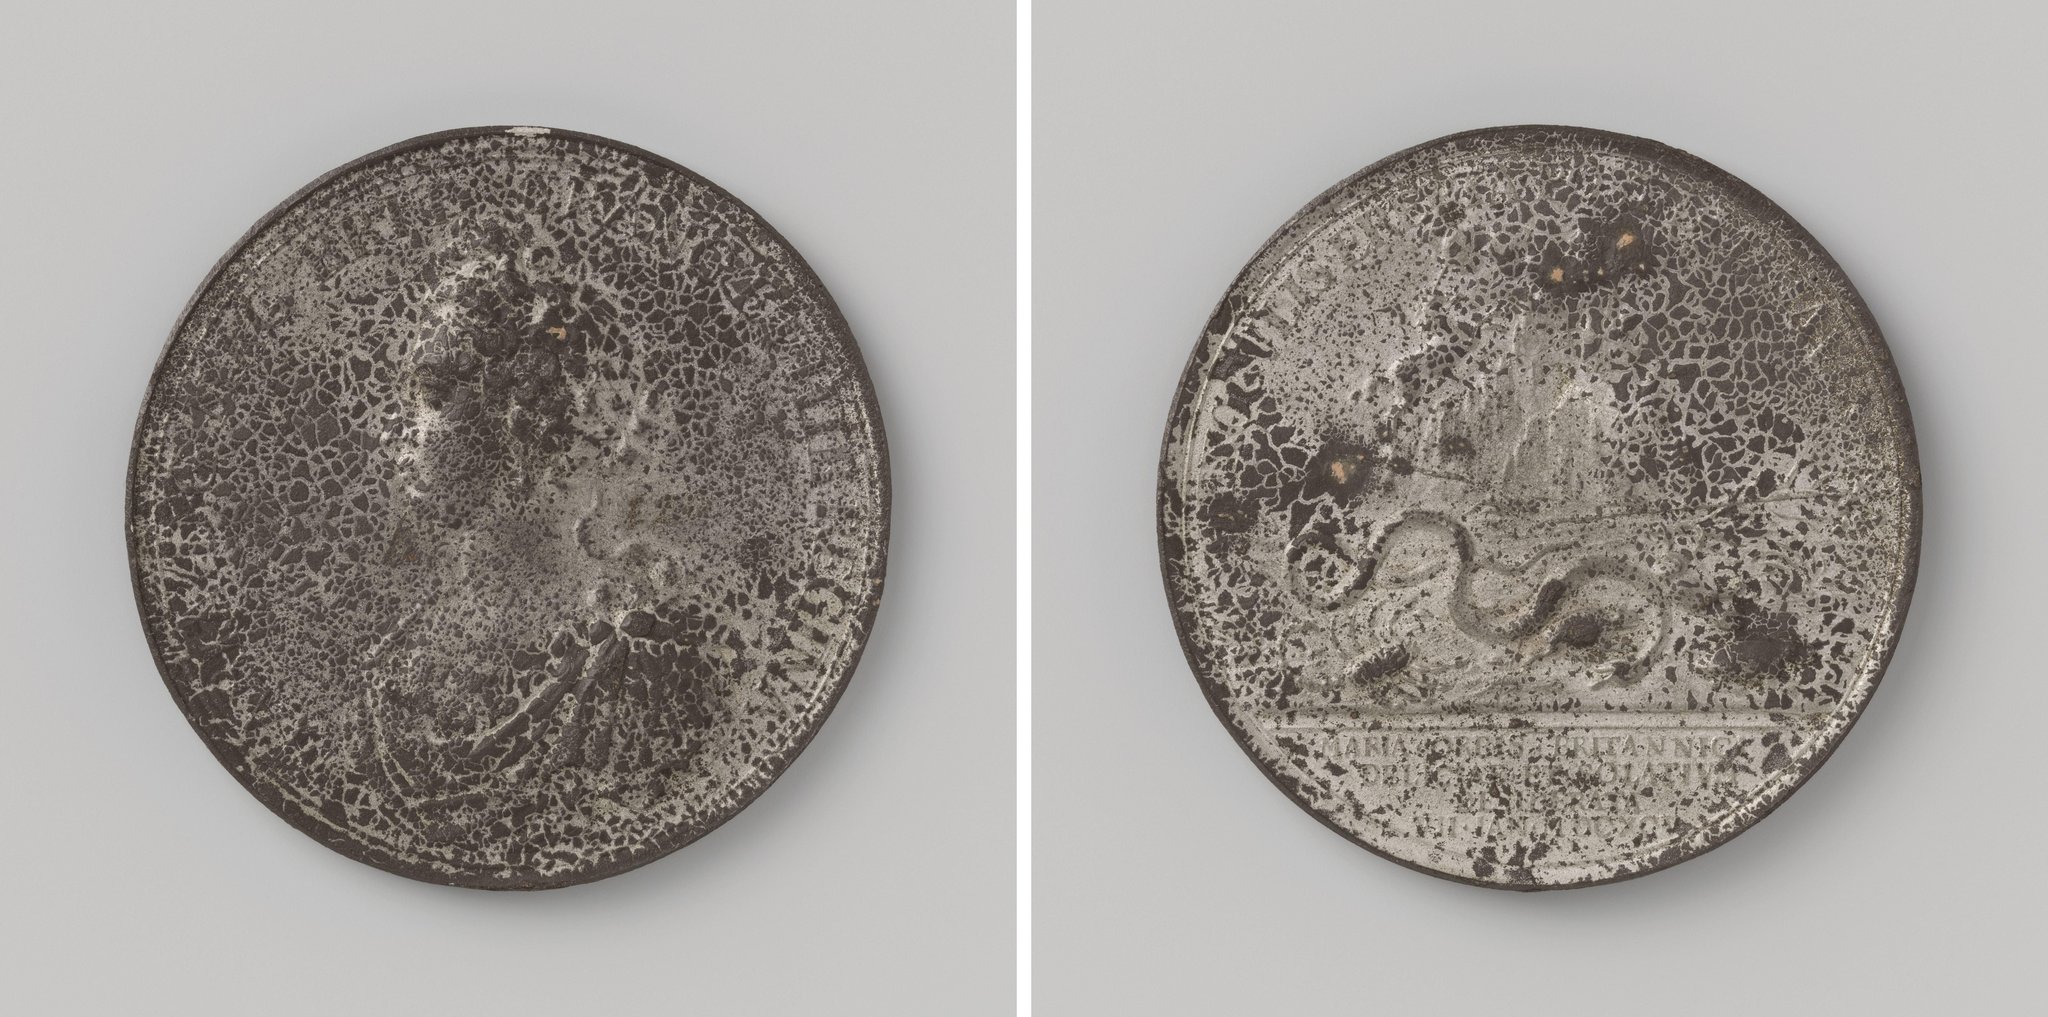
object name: copy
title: Overlijden van Maria II van Engeland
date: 1695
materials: silver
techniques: striking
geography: amsterdam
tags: london, maria ii stuart (koningin van engeland, schotland en ierland)